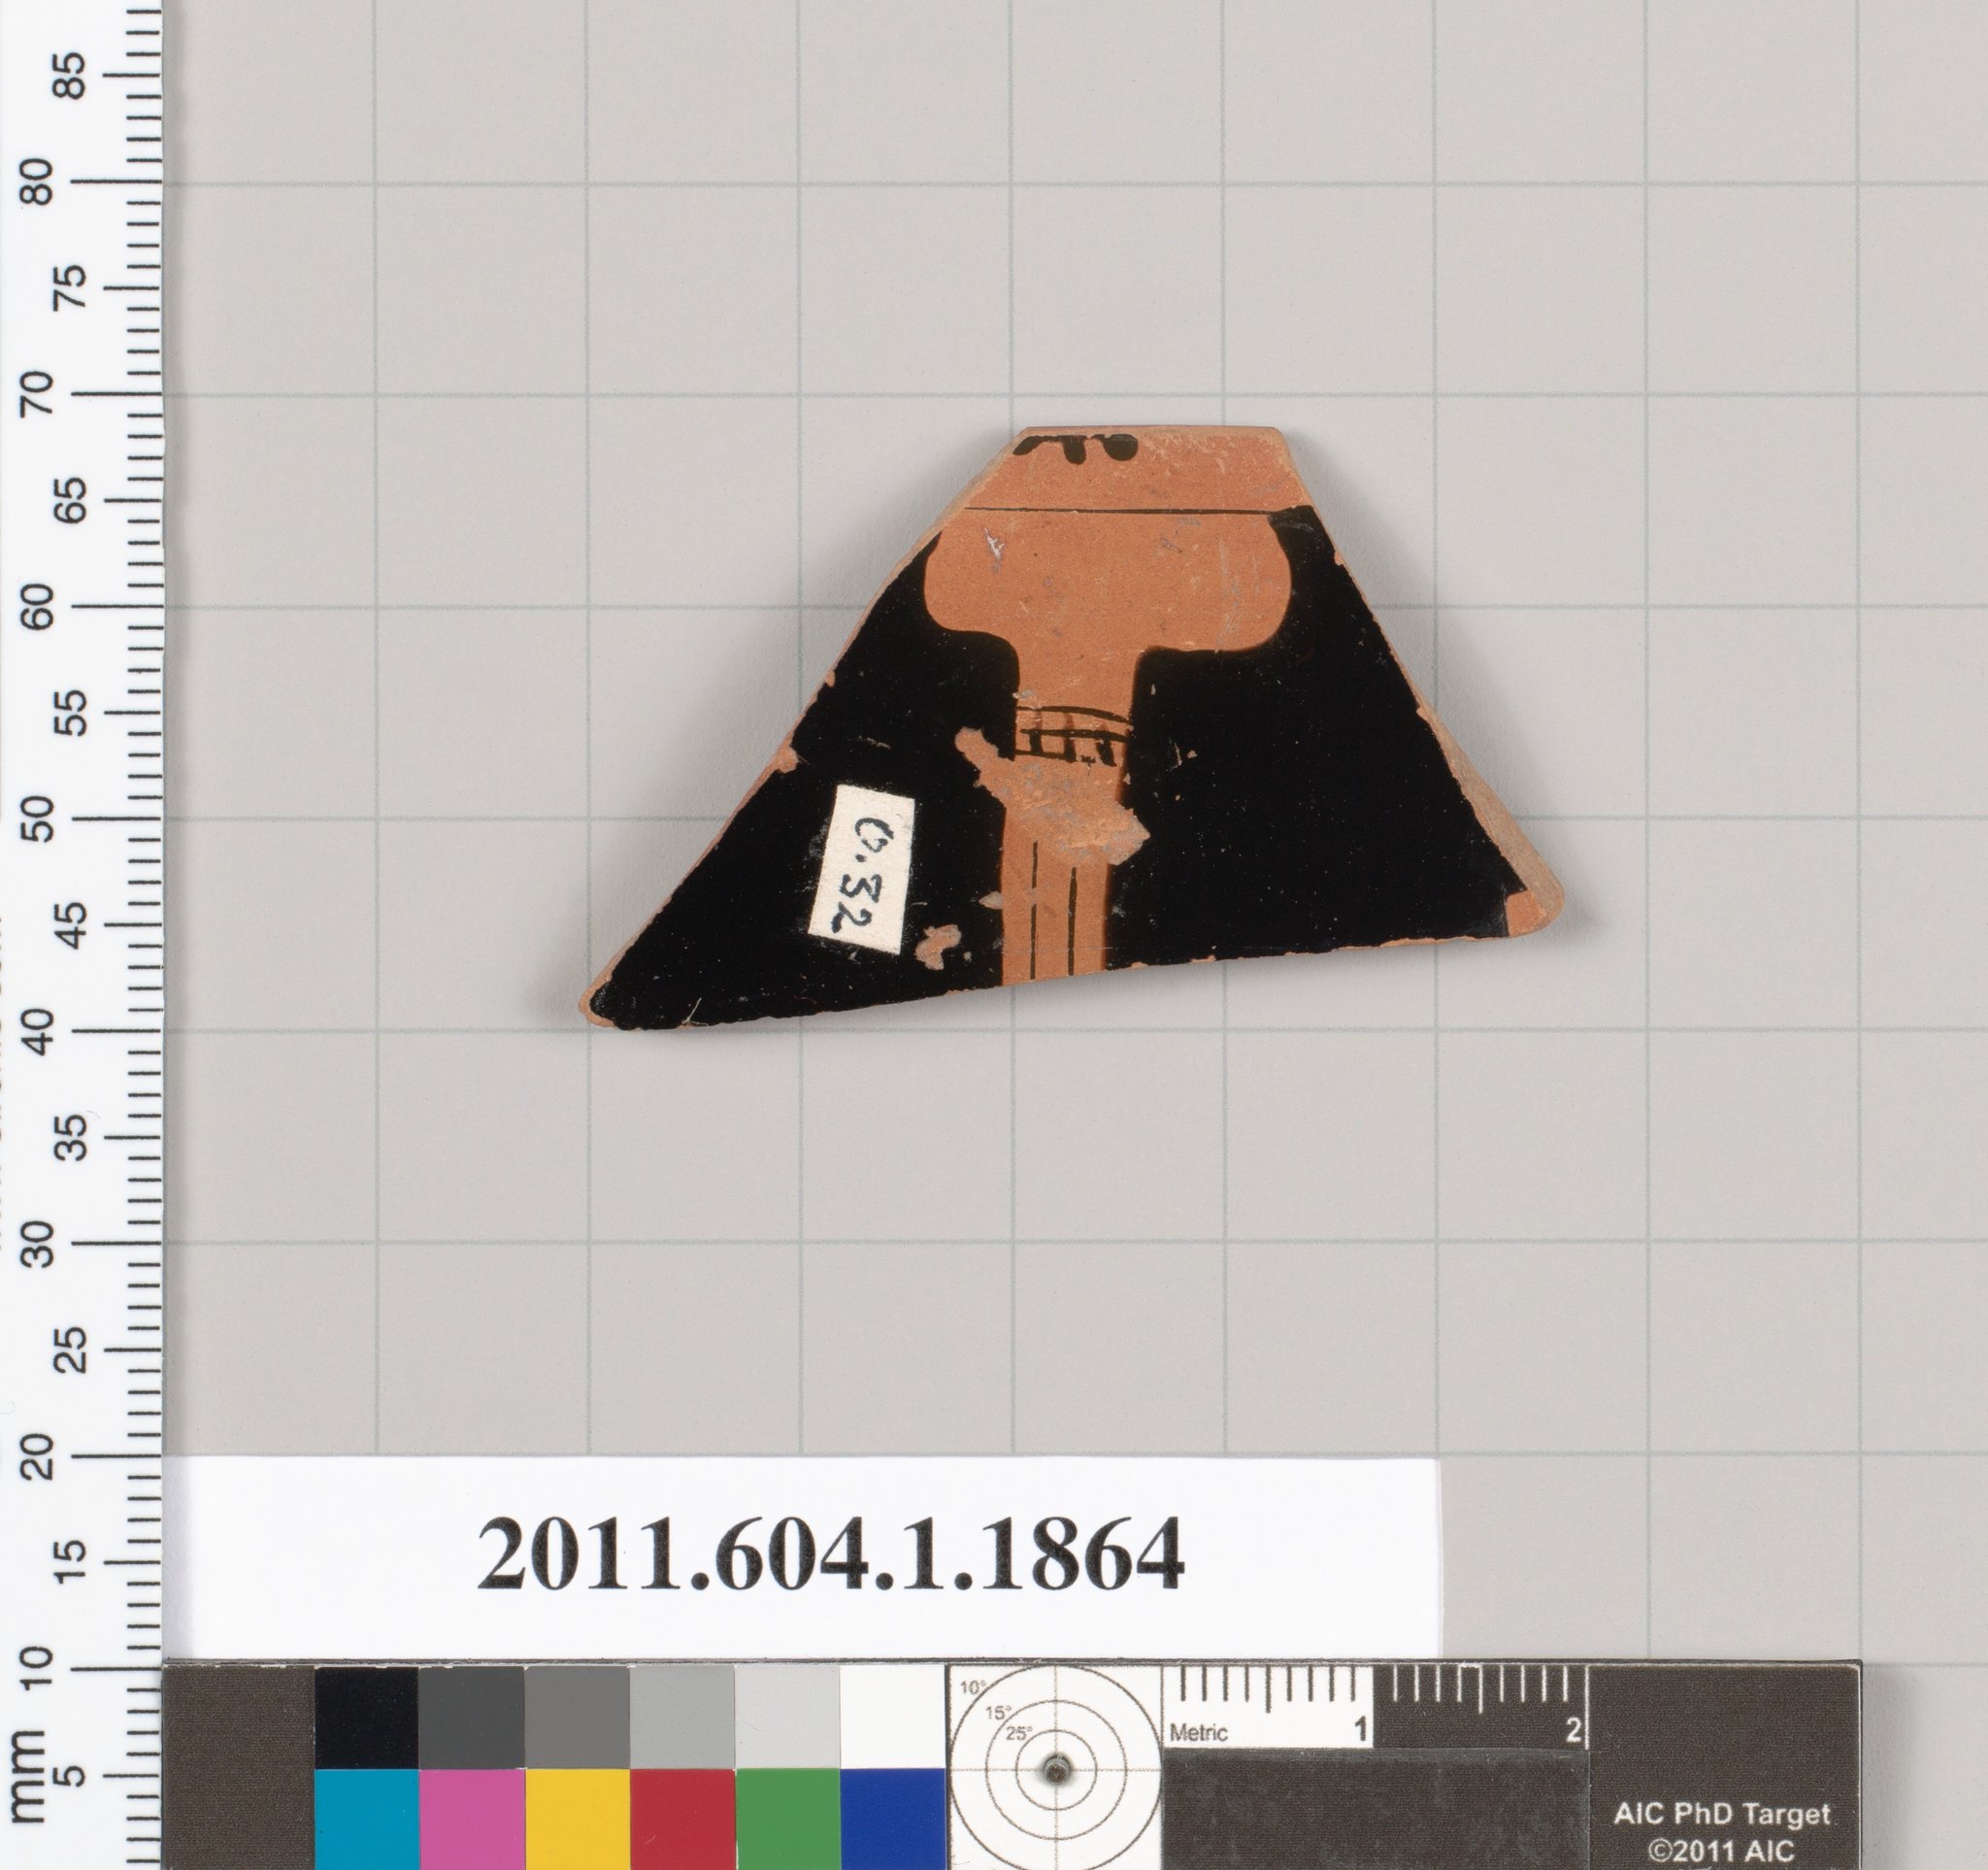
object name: kylix fragment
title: Terracotta rim fragment of a kylix (drinking cup)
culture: greek, attic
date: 475-451 BCE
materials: terracotta